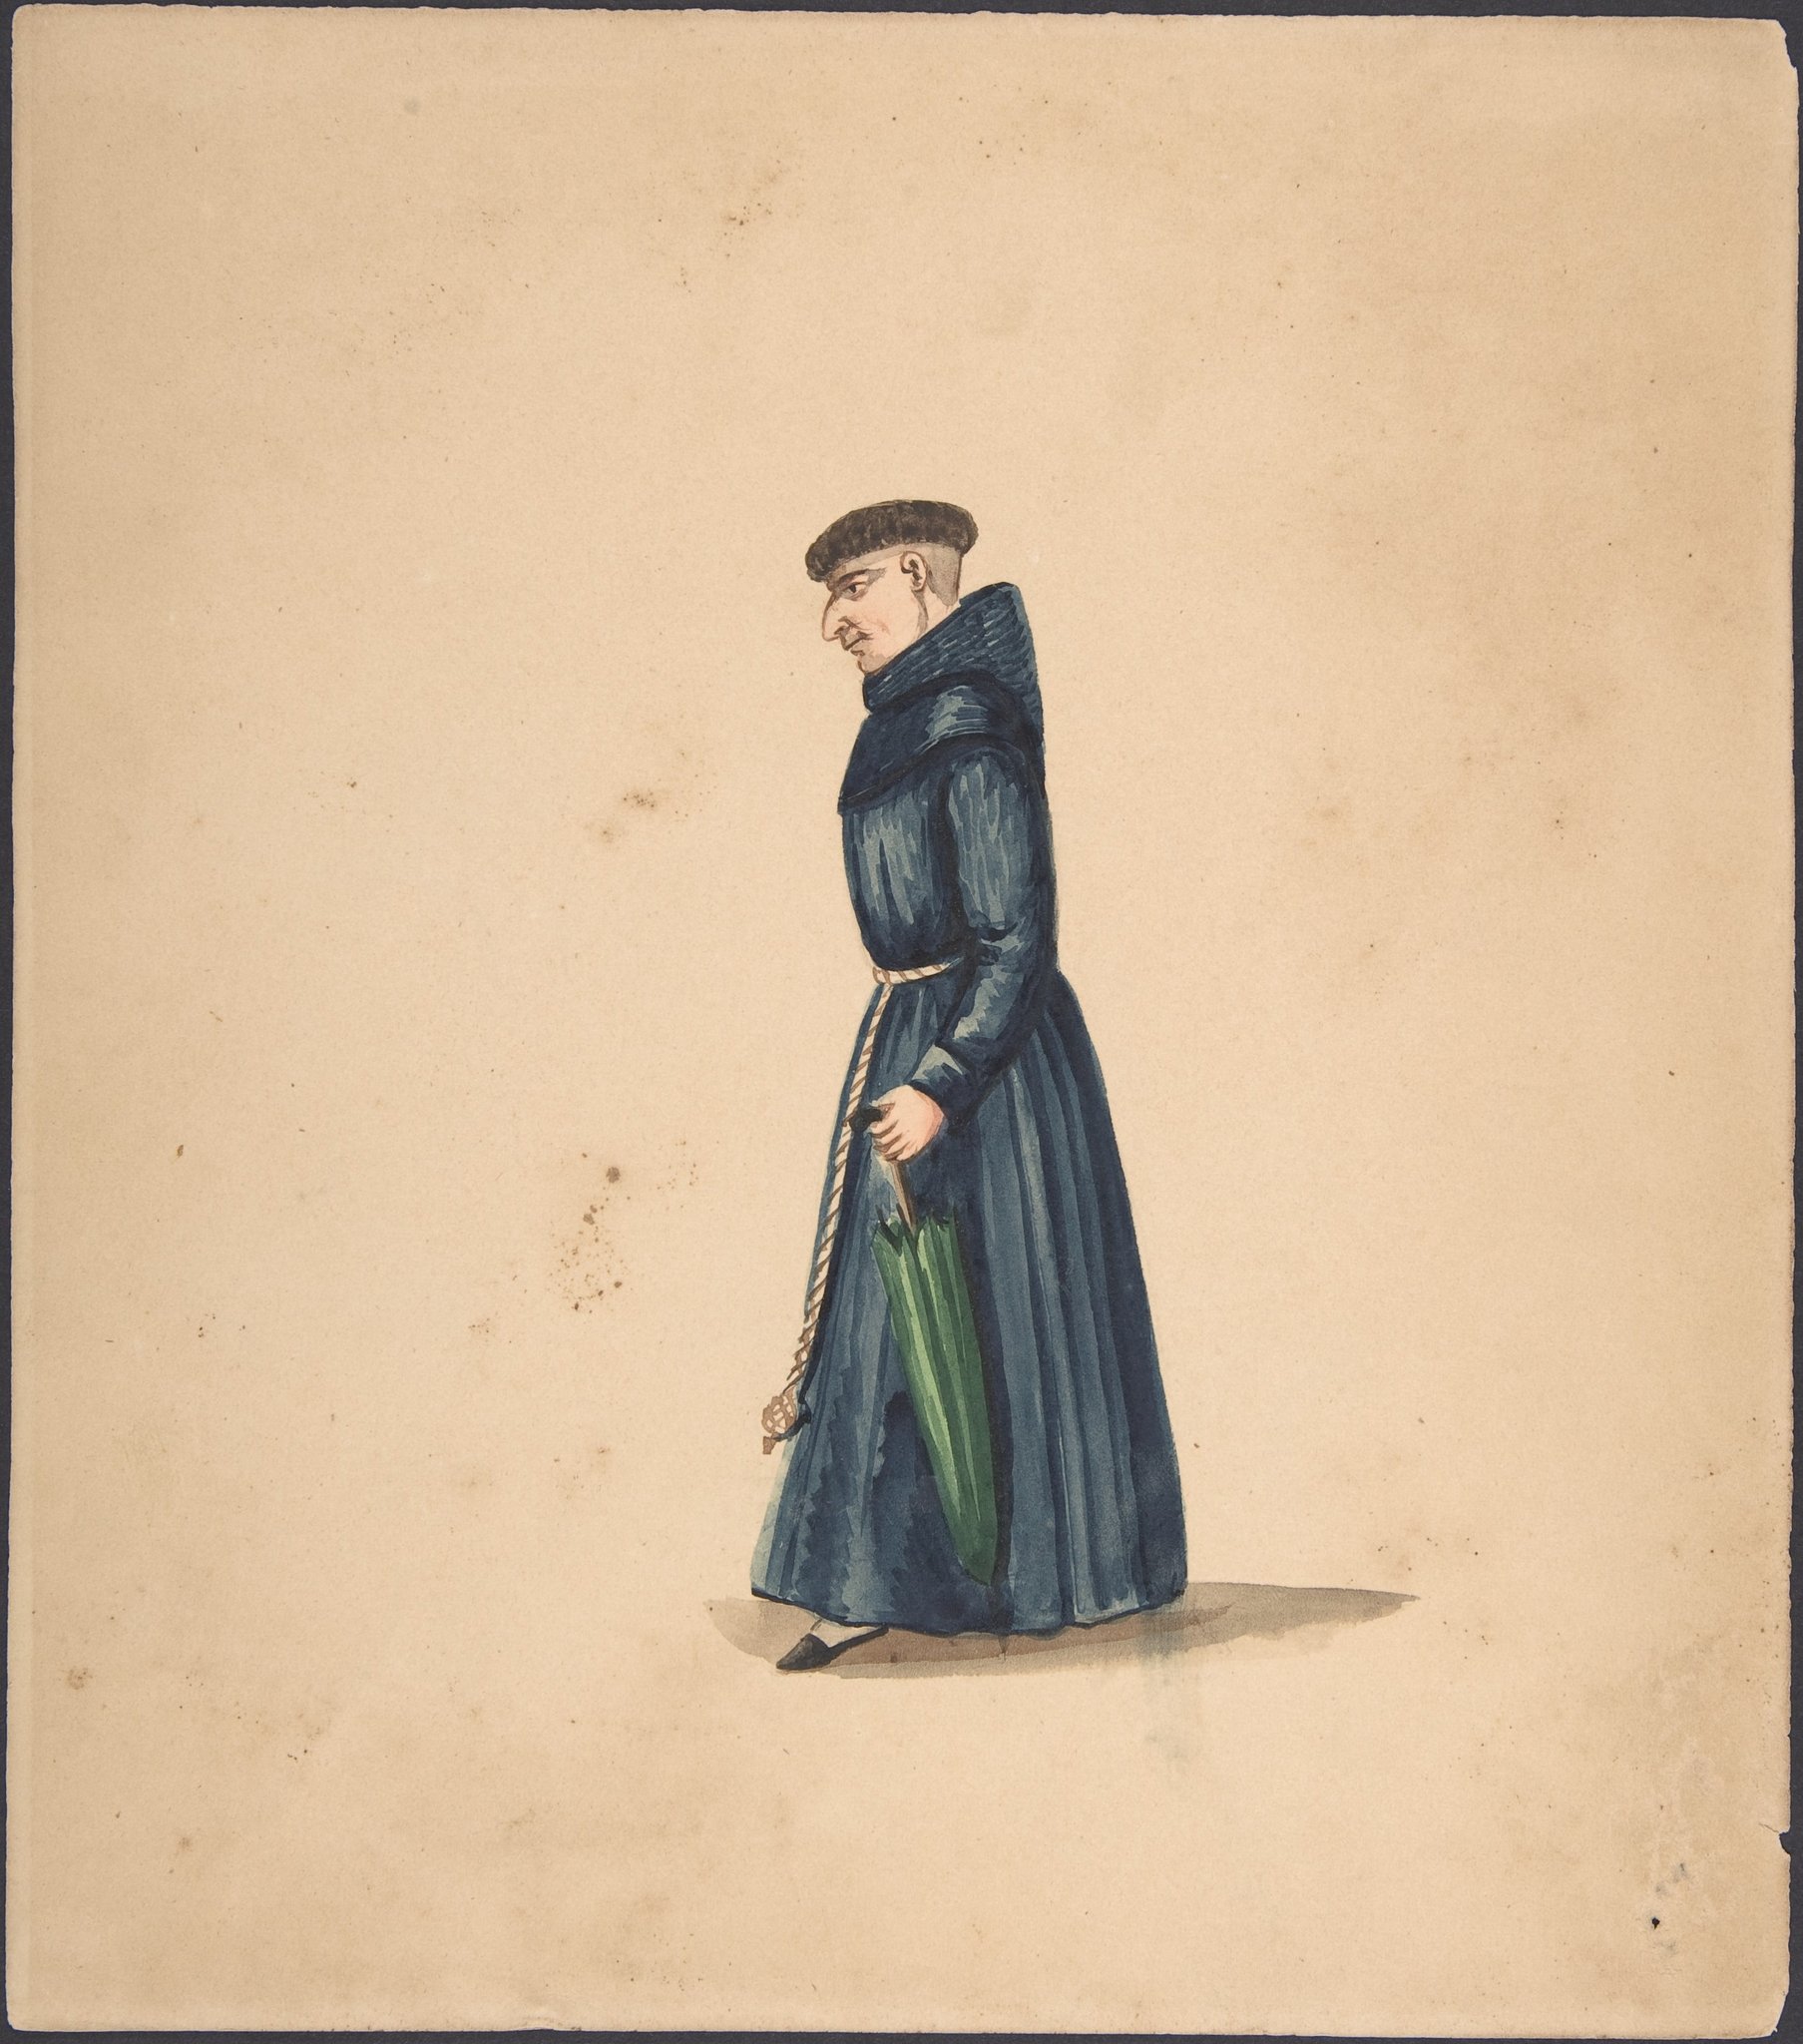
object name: drawing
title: A Priest with an Umbrella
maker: anonymous, peruvian, 19th century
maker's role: artist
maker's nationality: peruvian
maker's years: 1800-1900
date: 1840-1850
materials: ink, watercolor, paper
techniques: brush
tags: men,profiles